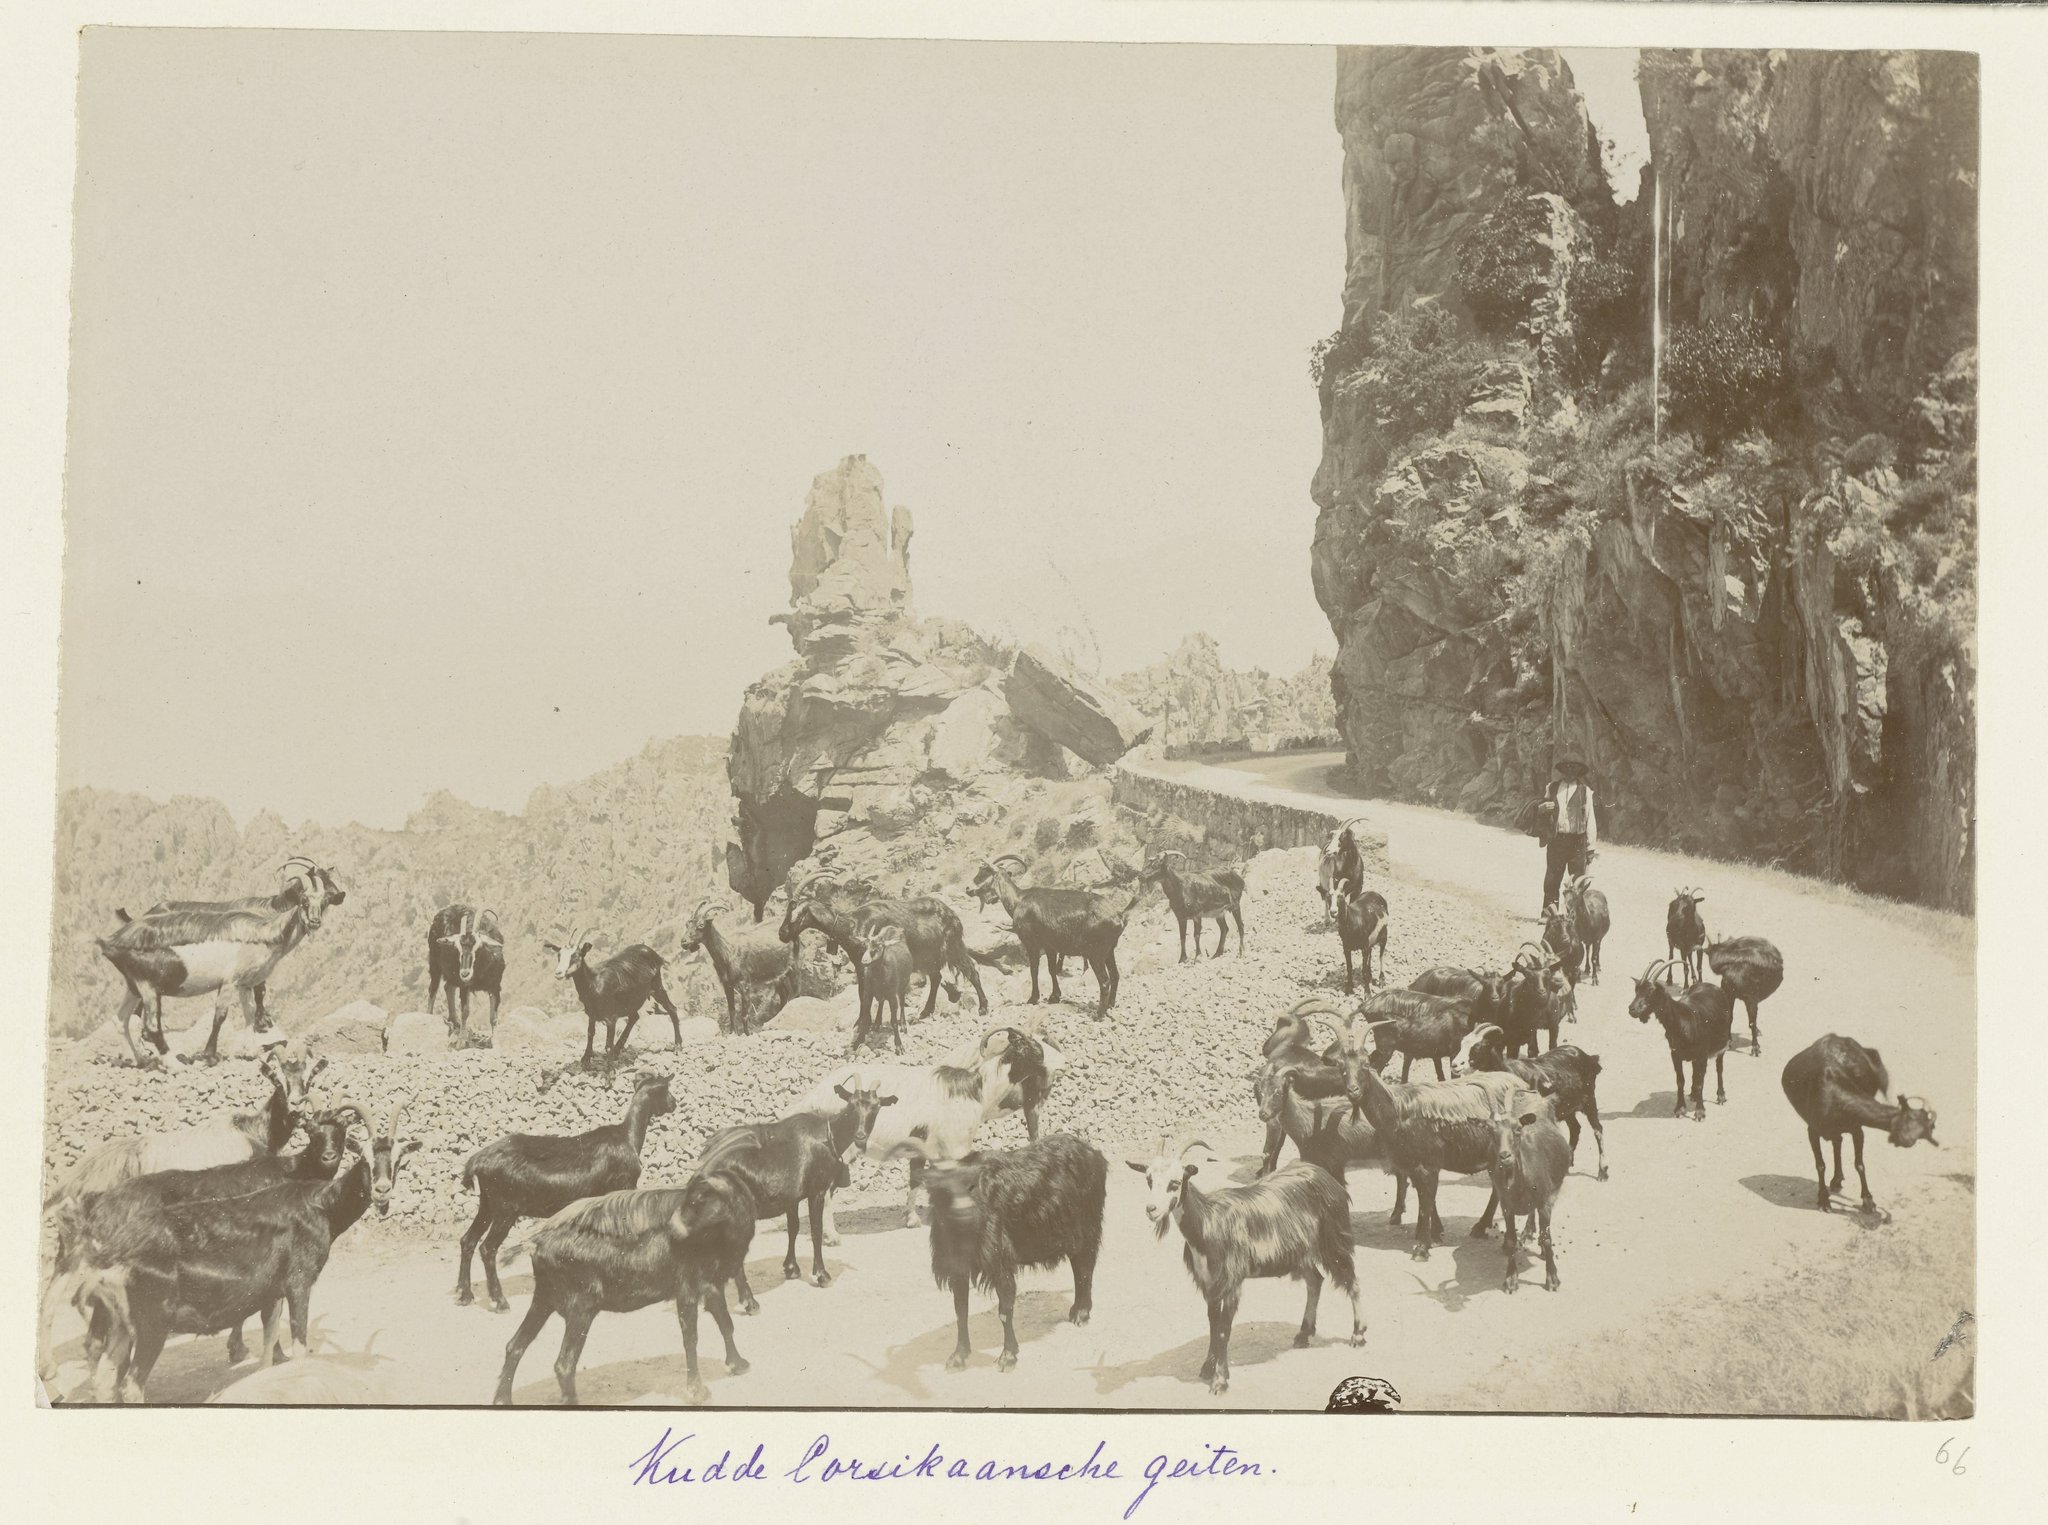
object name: photograph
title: Geiten en geitenhoeder op de weg in het bergachtige Corsicaanse landschap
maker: henry pauw van wieldrecht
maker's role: fotograaf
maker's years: 1863-1912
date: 1886-1896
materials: cardboard, photographic support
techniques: albumen print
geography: corsica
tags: corsica